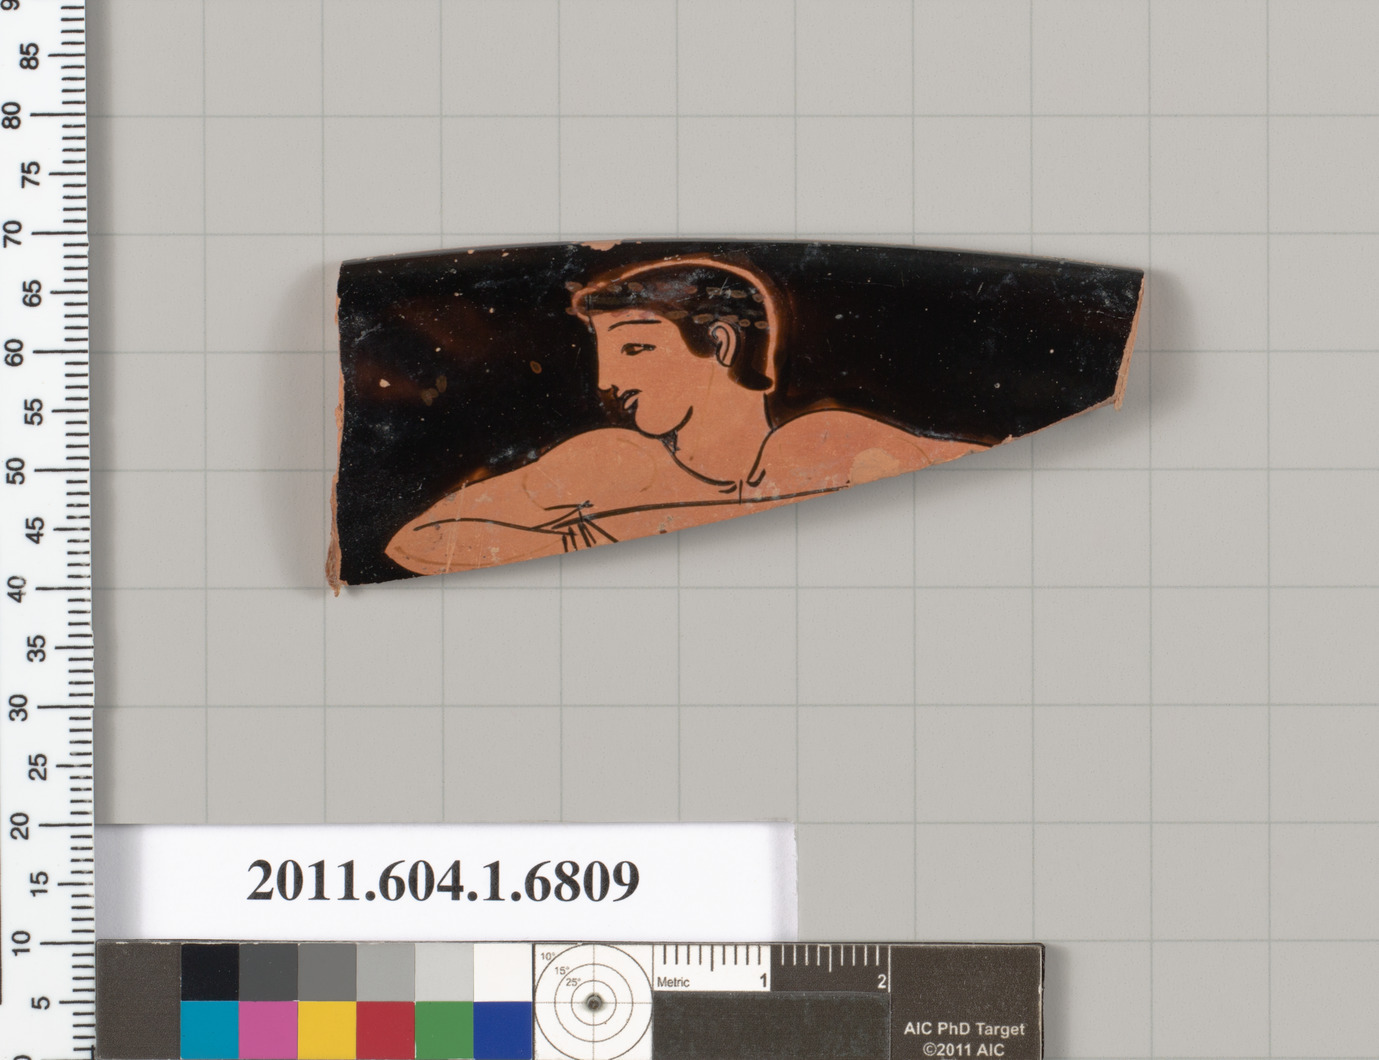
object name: kylix fragment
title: Terracotta rim fragment of a kylix (drinking cup)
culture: greek, attic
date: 490-470 BCE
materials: terracotta